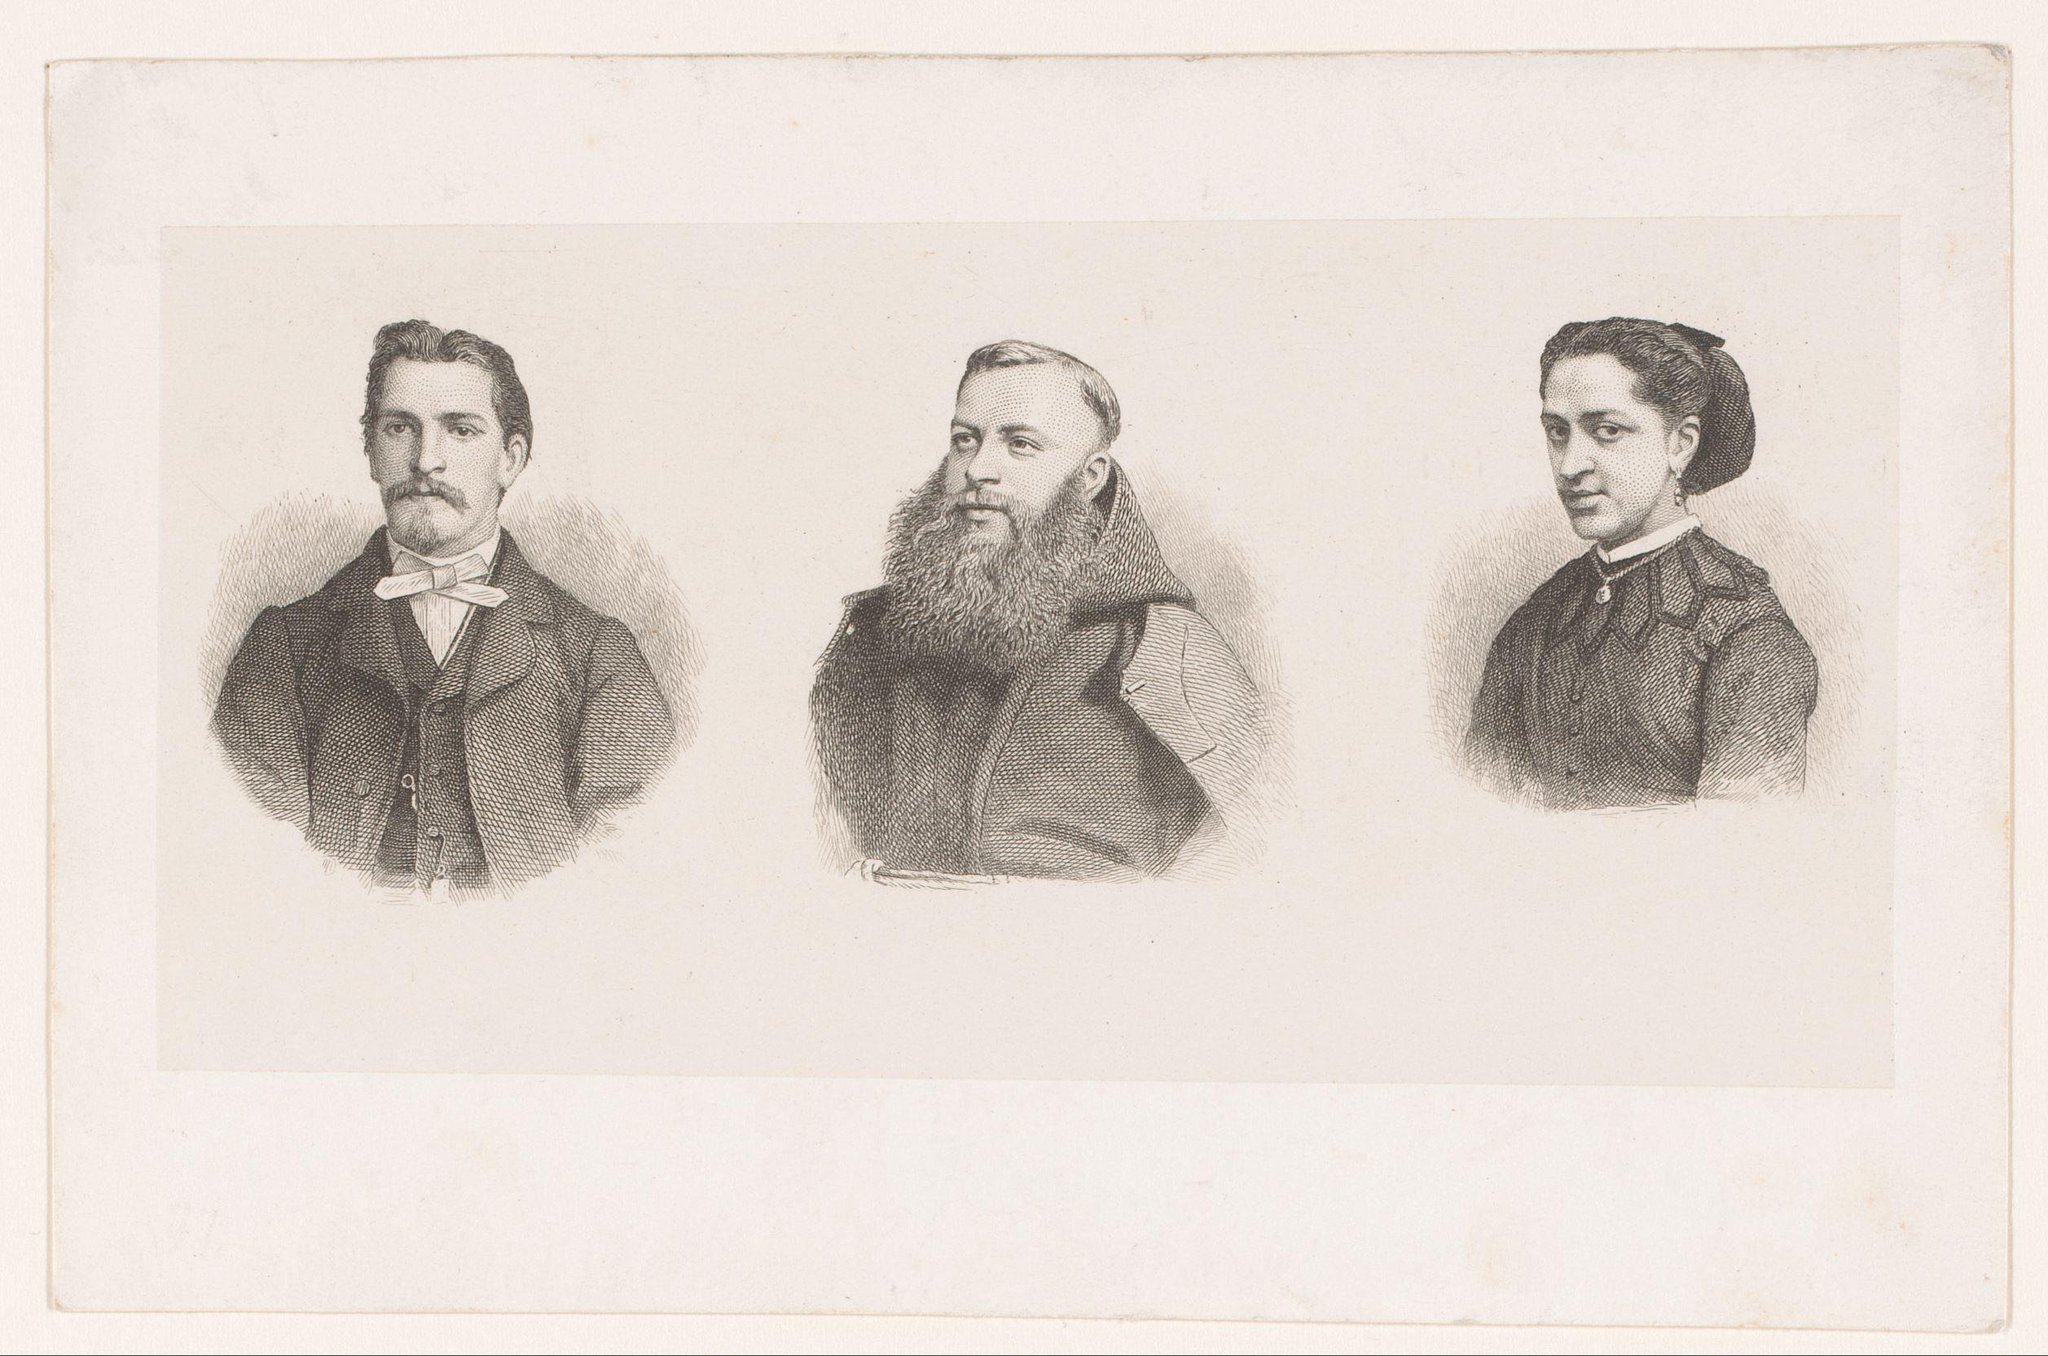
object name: print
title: Drie onbekende portretten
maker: jean baptiste pierre michiels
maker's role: print maker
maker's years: 1821-1890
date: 1831-1890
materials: paper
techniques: etching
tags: adult woman, adult man, historical persons, monk(s), friar(s)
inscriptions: collector's mark: Lugt 2228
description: Een detail van een latere staat van deze prent heeft bij de middelste persoon het onderschrift: 'Fr. Aloysius [cosure]'. Zie hiervoor RP-P-1913-1859. De vrouw op de prent is volgens de inventaris mogelijk Colette van Spilbeeck.